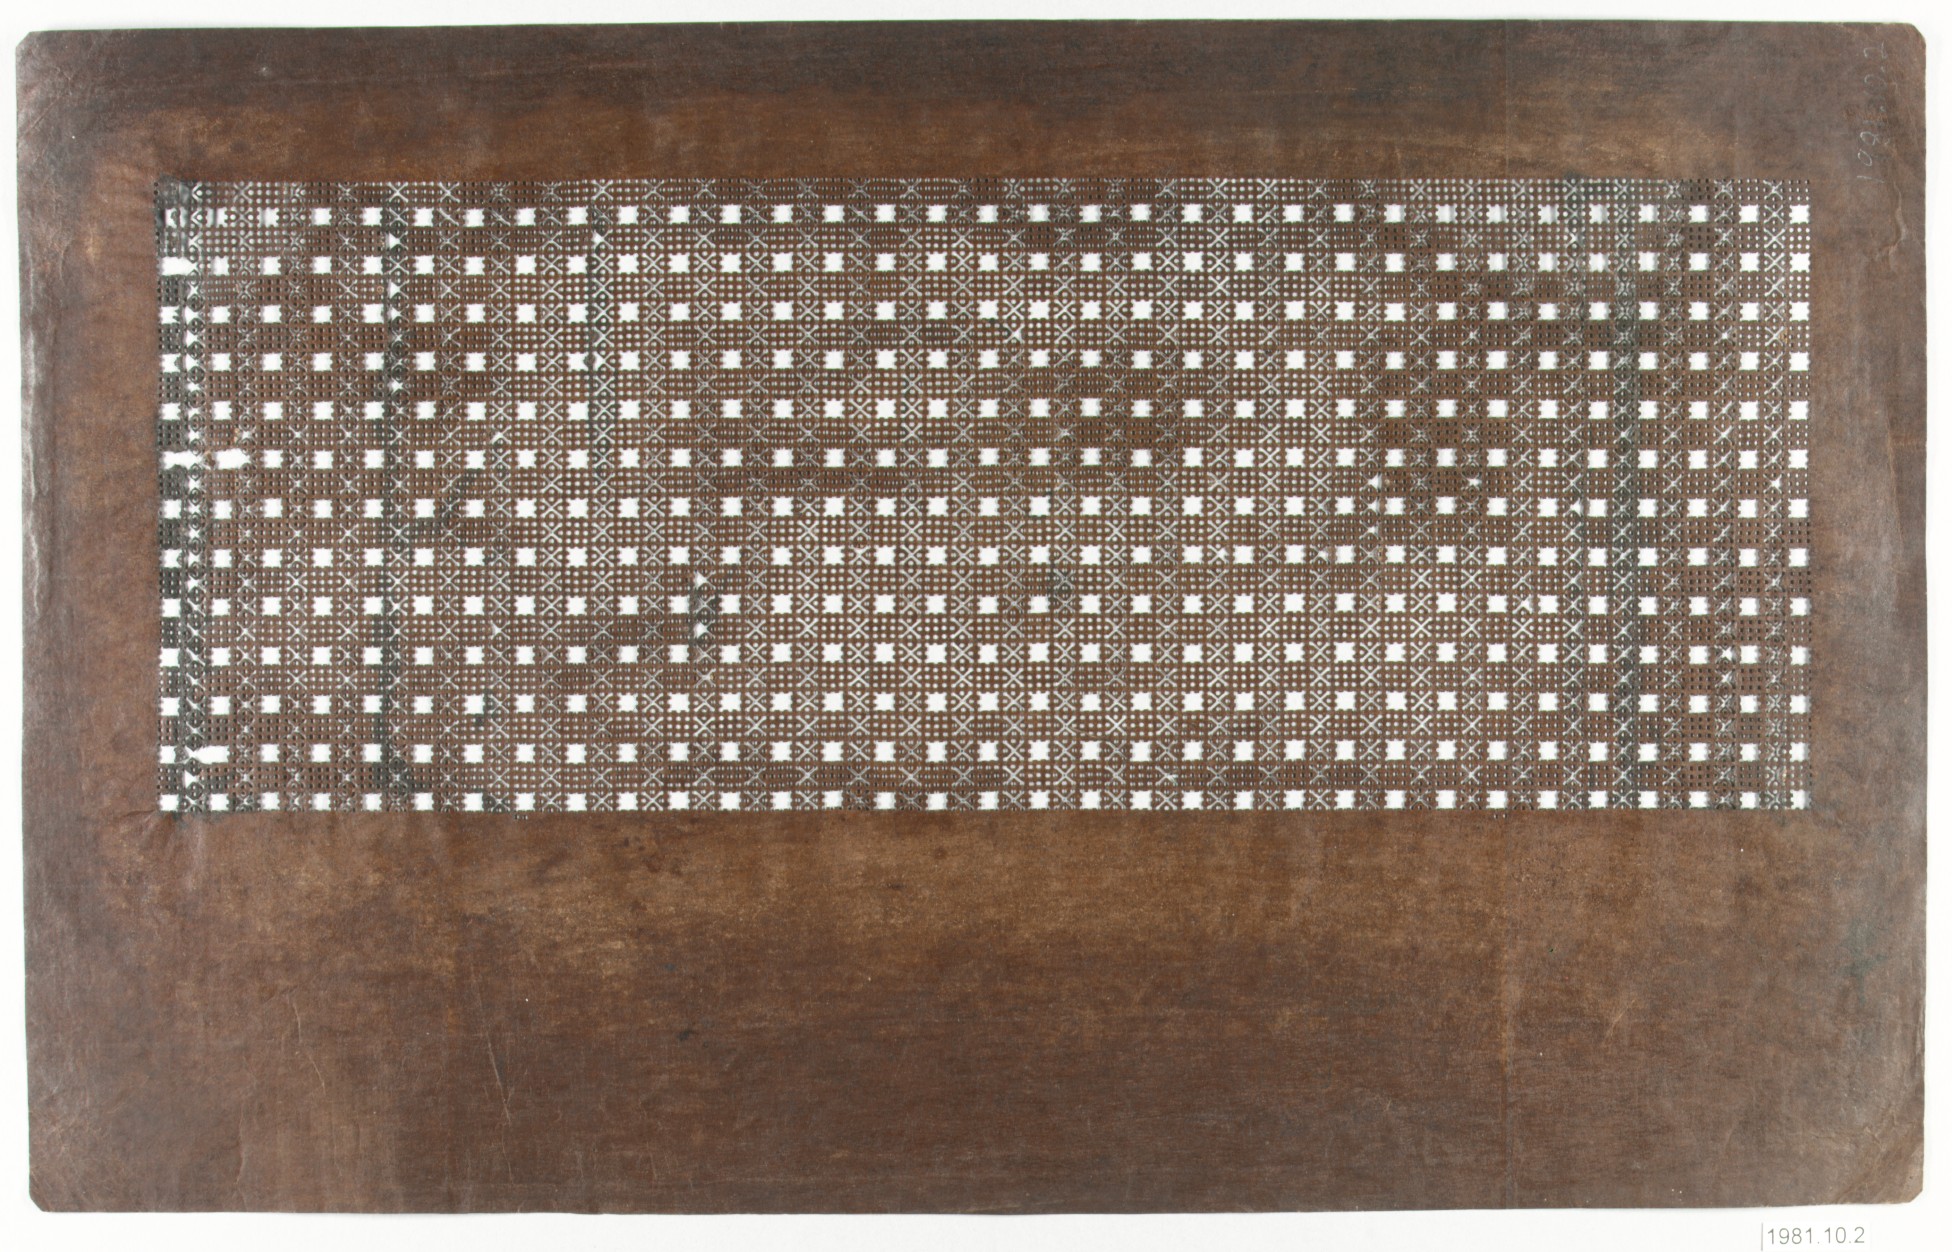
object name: stencil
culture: japanese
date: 1801-1900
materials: paper